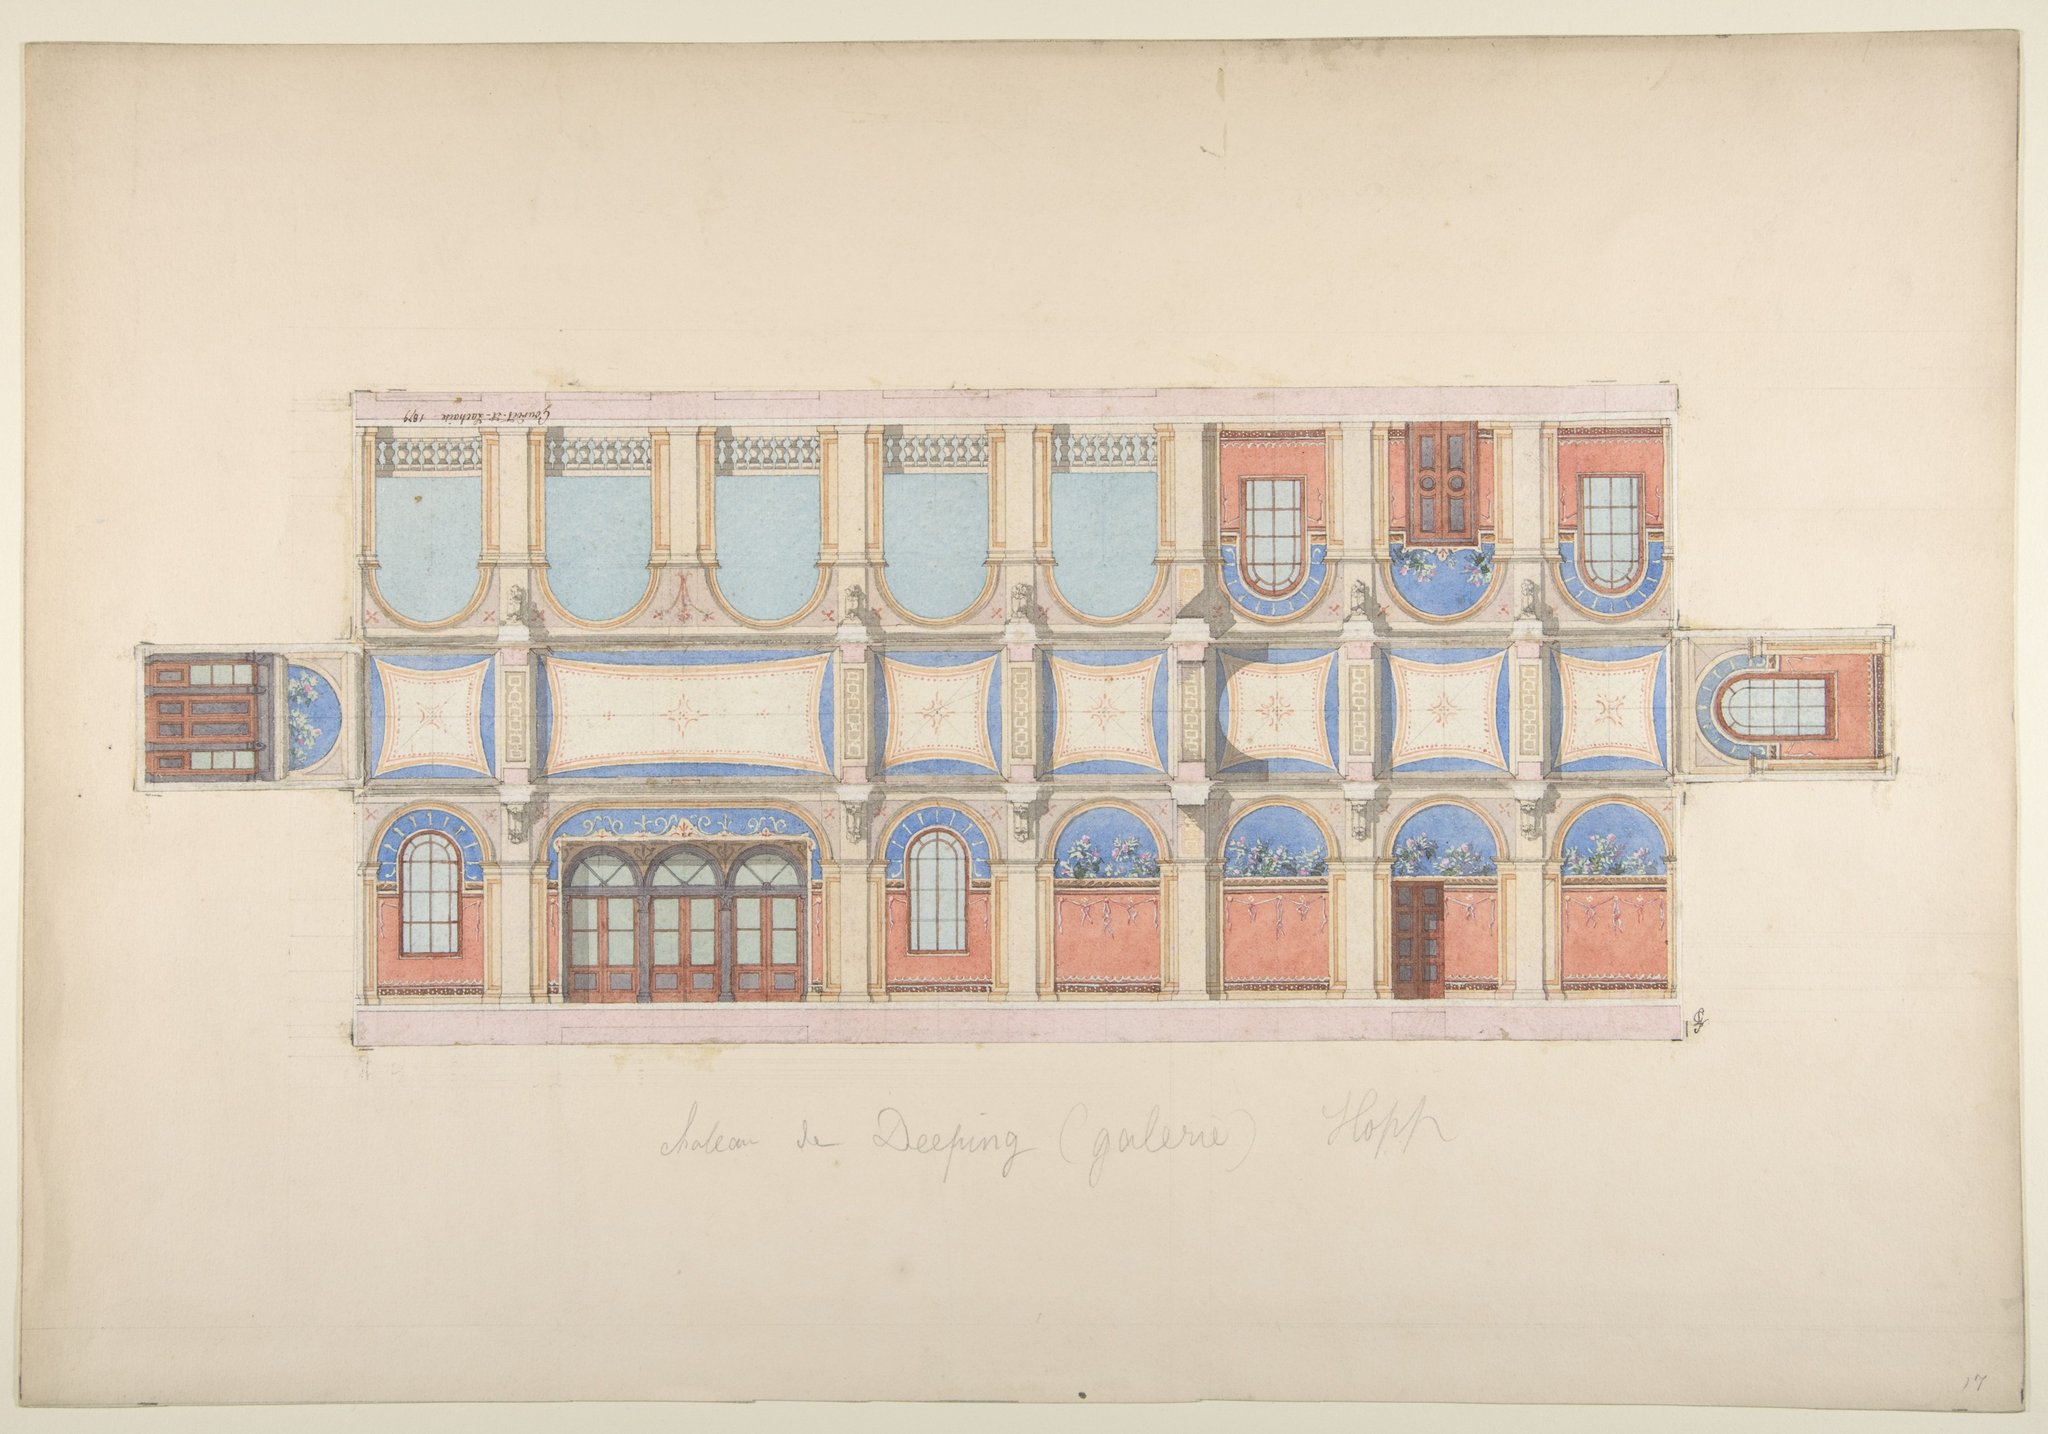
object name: drawing ornament architecture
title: Plan and Elevation of Gallery, Deepdene, Dorking, Surrey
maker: jules-edmond-charles lachaise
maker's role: artist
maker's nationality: french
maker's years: 1897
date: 1875-1879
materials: graphite, ink, watercolor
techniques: pen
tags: architecture